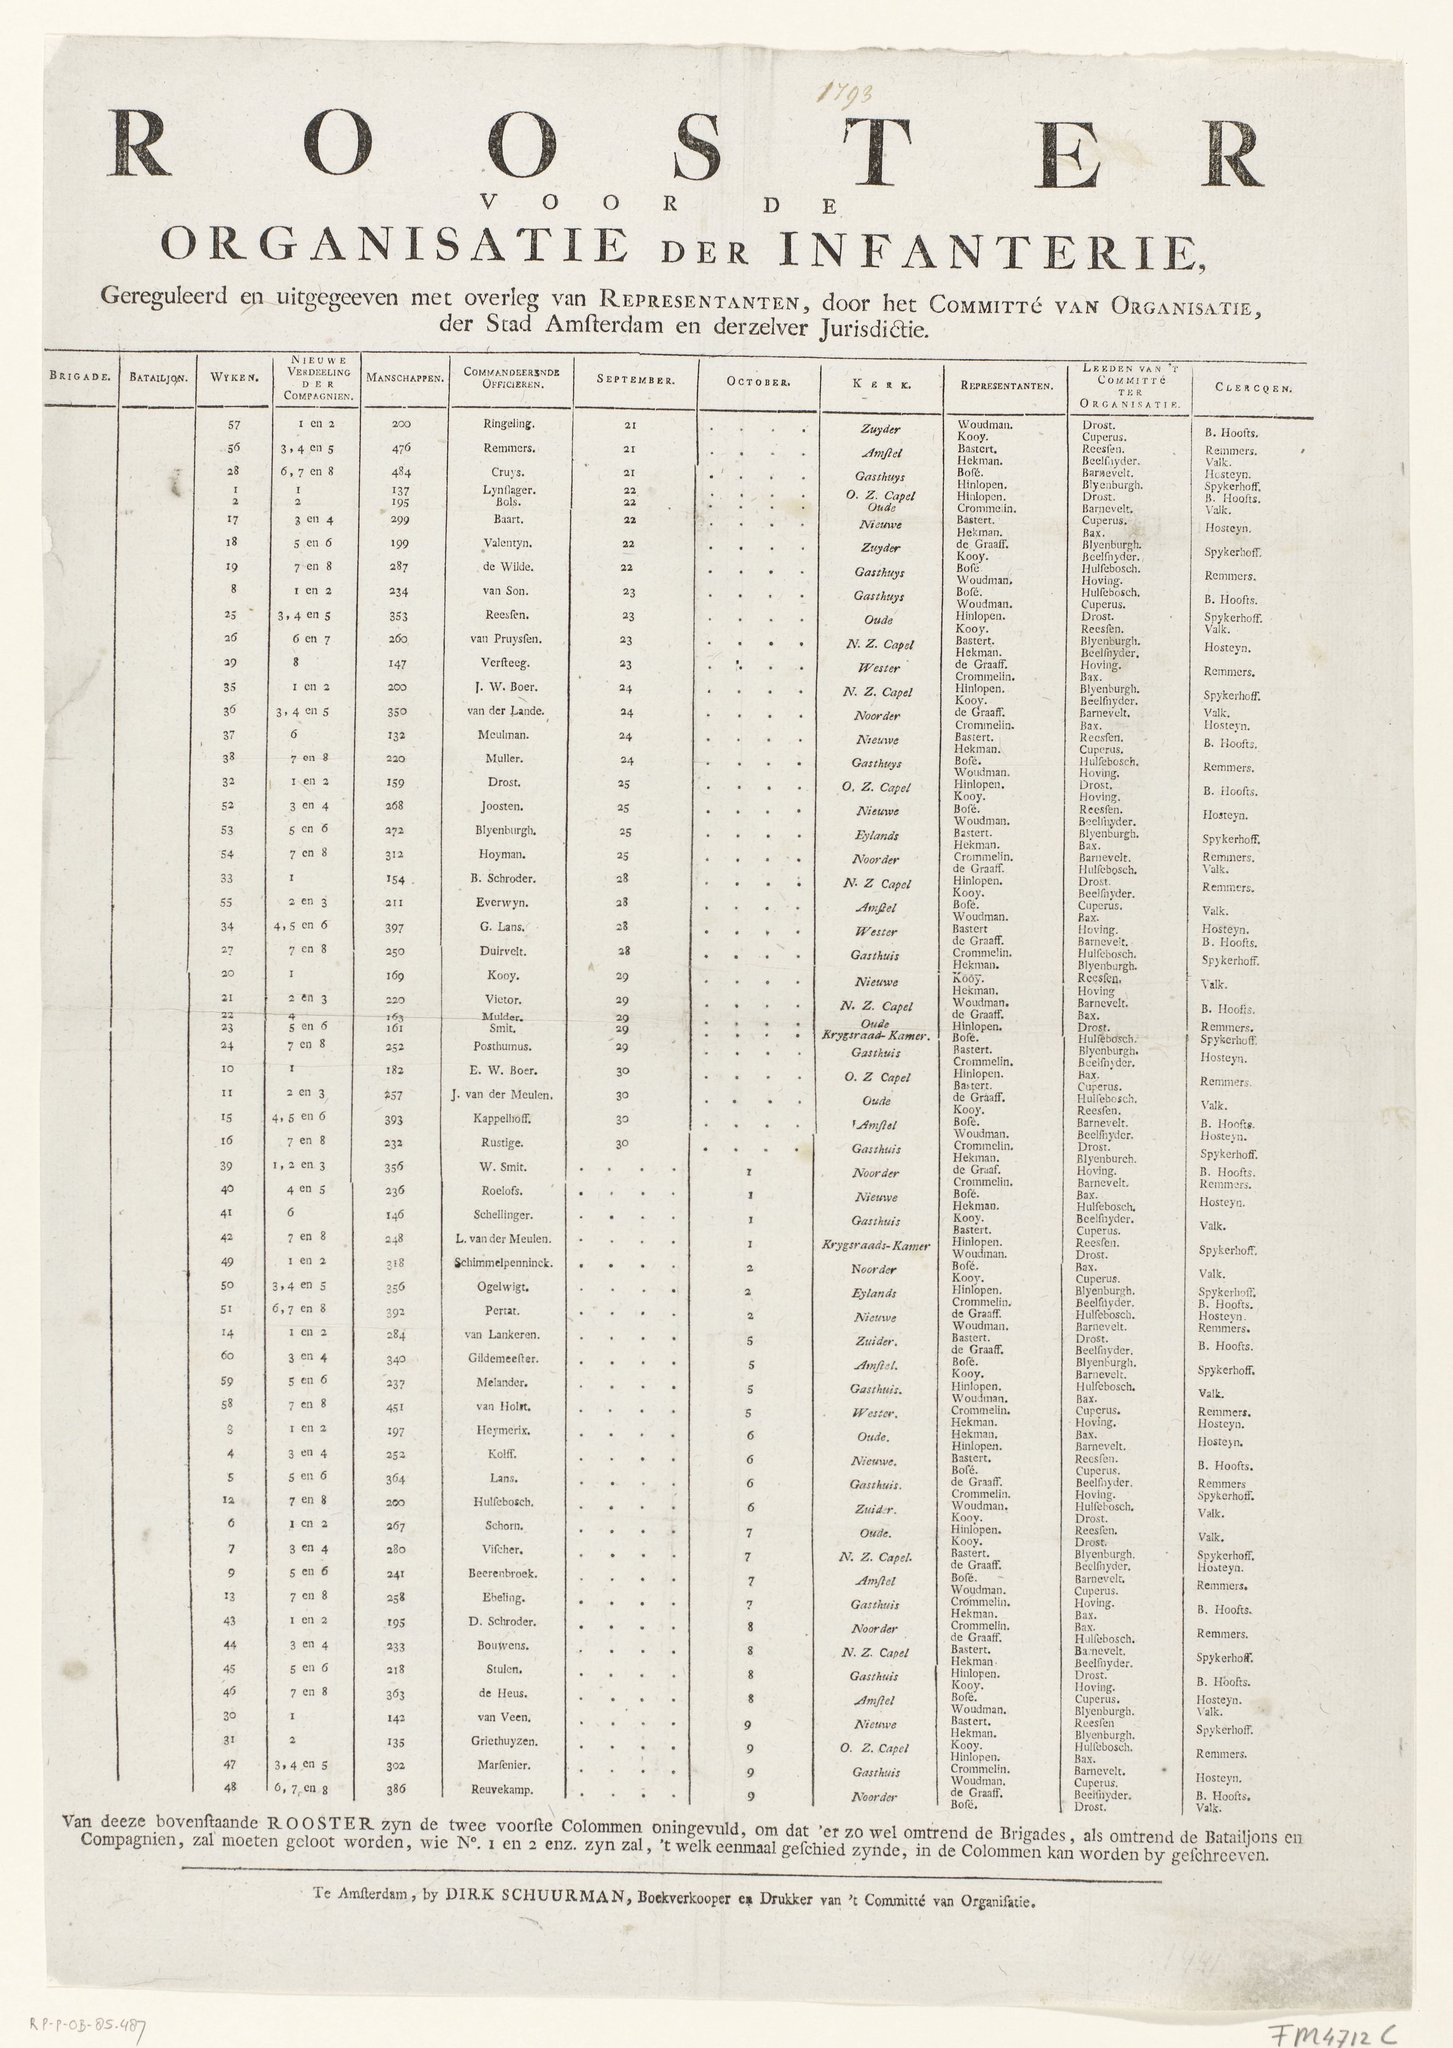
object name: text sheet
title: Rooster voor de organisatie van de Amsterdamse schutterij, ca. 1790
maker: dirk schuurman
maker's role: printer, publisher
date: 1786-1793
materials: paper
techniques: letterpress printing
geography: amsterdam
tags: insignia; division of armed forces; ranks (+ citizen soldiery, civil guard, citizen militia), amsterdam, patriots (1780-1795)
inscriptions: collector's mark: Lugt 2228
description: Rooster voor de organisatie van de Amsterdamse schutterij, ca. 1790. Tekstblad met kolommen voor de compagnieën, wijken, aantallen manschappen, commanderende officieren, data in de maanden september en oktober en vertegenwoordigers.